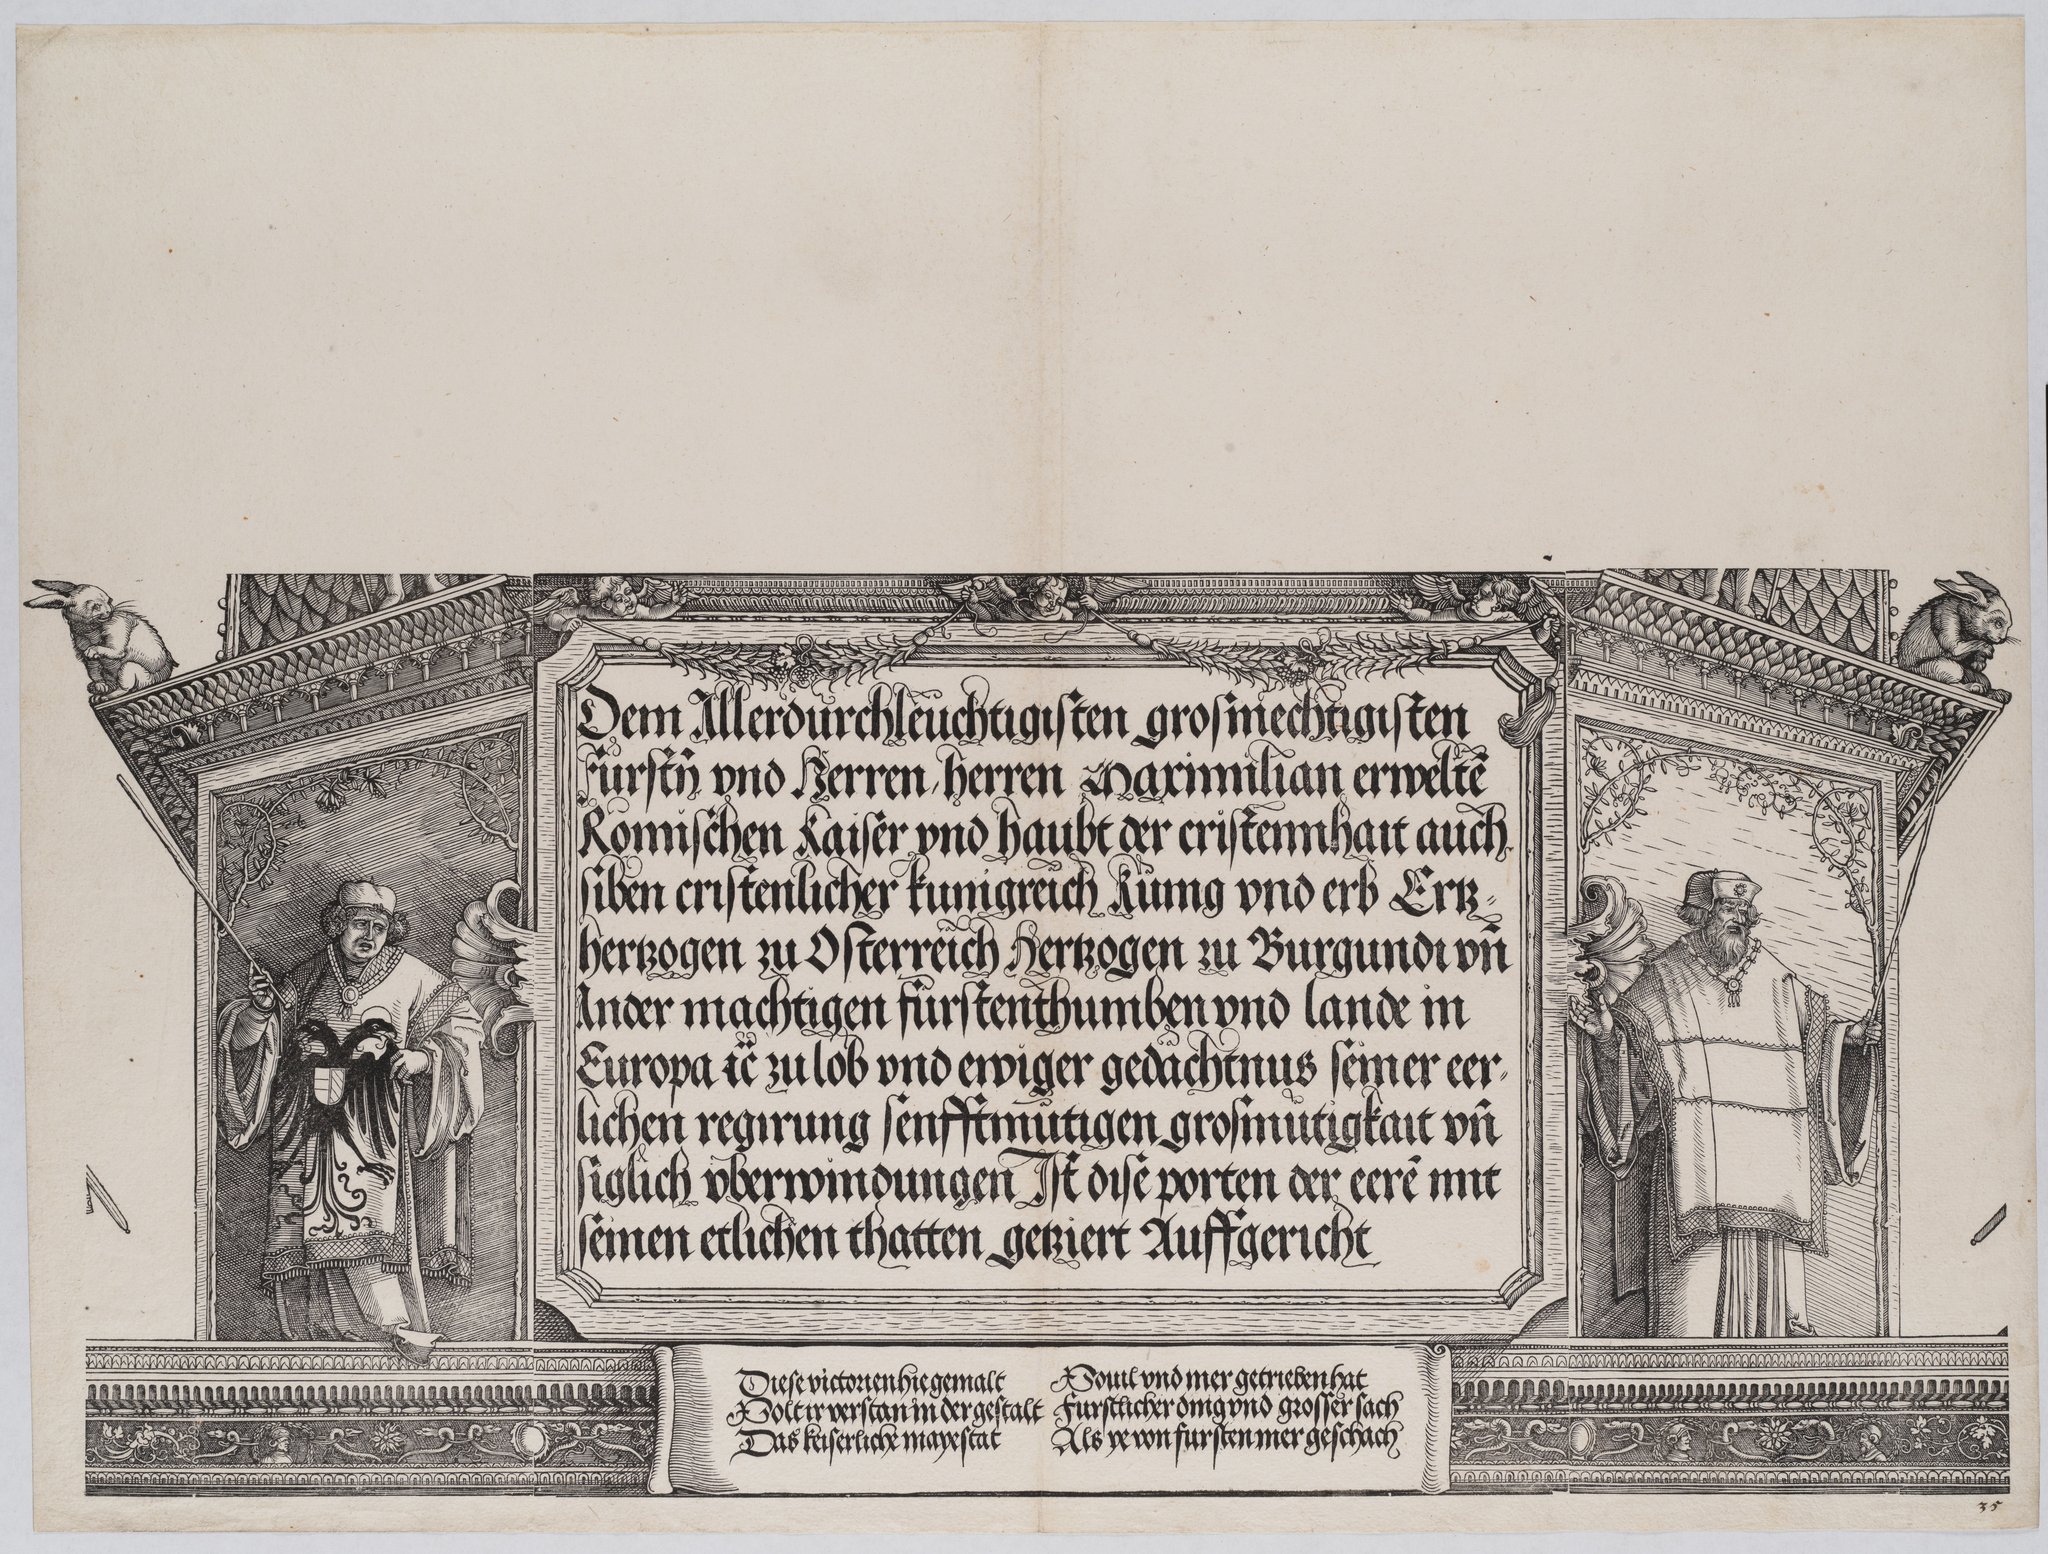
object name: print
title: The Lower Portiion of the Cupola of the Central Portal, with Herolds Flanking a Central Placard, from the Arch of Honor, proof, dated 1515, printed 1517-18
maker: hans springinklee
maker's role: artist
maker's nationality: german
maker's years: 1495-1530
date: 1515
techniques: letterpress, woodcut